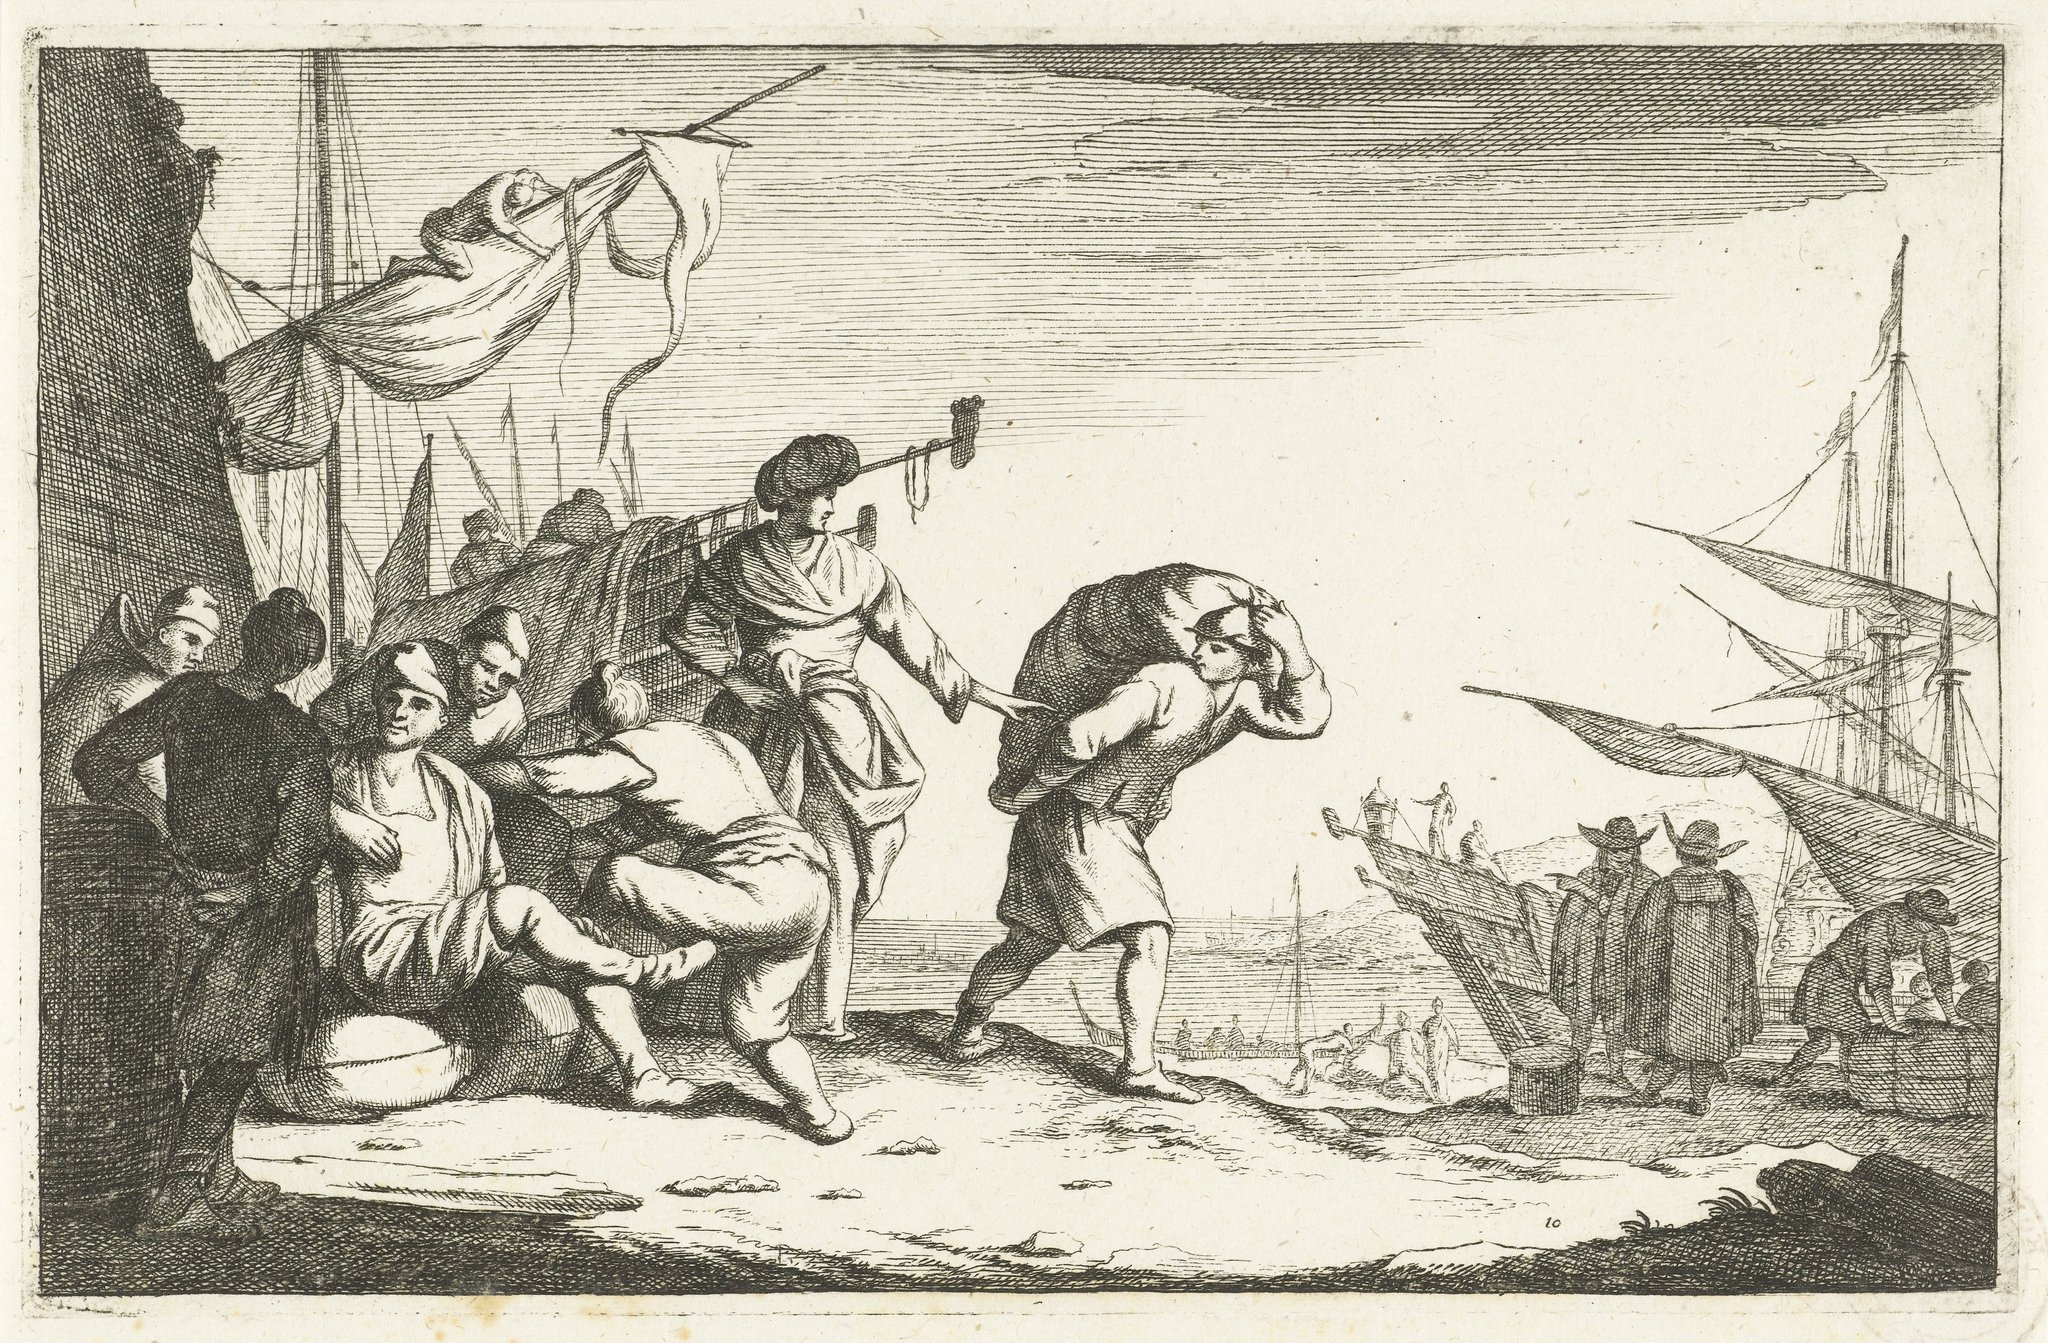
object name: print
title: Aliqui Portus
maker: johannes gronsveld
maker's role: draughtsman, painter, print maker, publisher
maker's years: 1658-1728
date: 1679-1728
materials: paper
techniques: engraving, etching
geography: amsterdam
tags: harbour (+ four persons or more ~ traffic and transport)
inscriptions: collector's mark: Lugt 240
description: Haven met links een groep buitenlandse kooplieden die lading sjouwen. Rechts een zeilschip met kooplieden. Aan de kade een tweede zeilschip met kooplieden. Op de achtergrond uitzicht op zee. Tiende prent uit een serie van twaalf met Italiaanse havens.